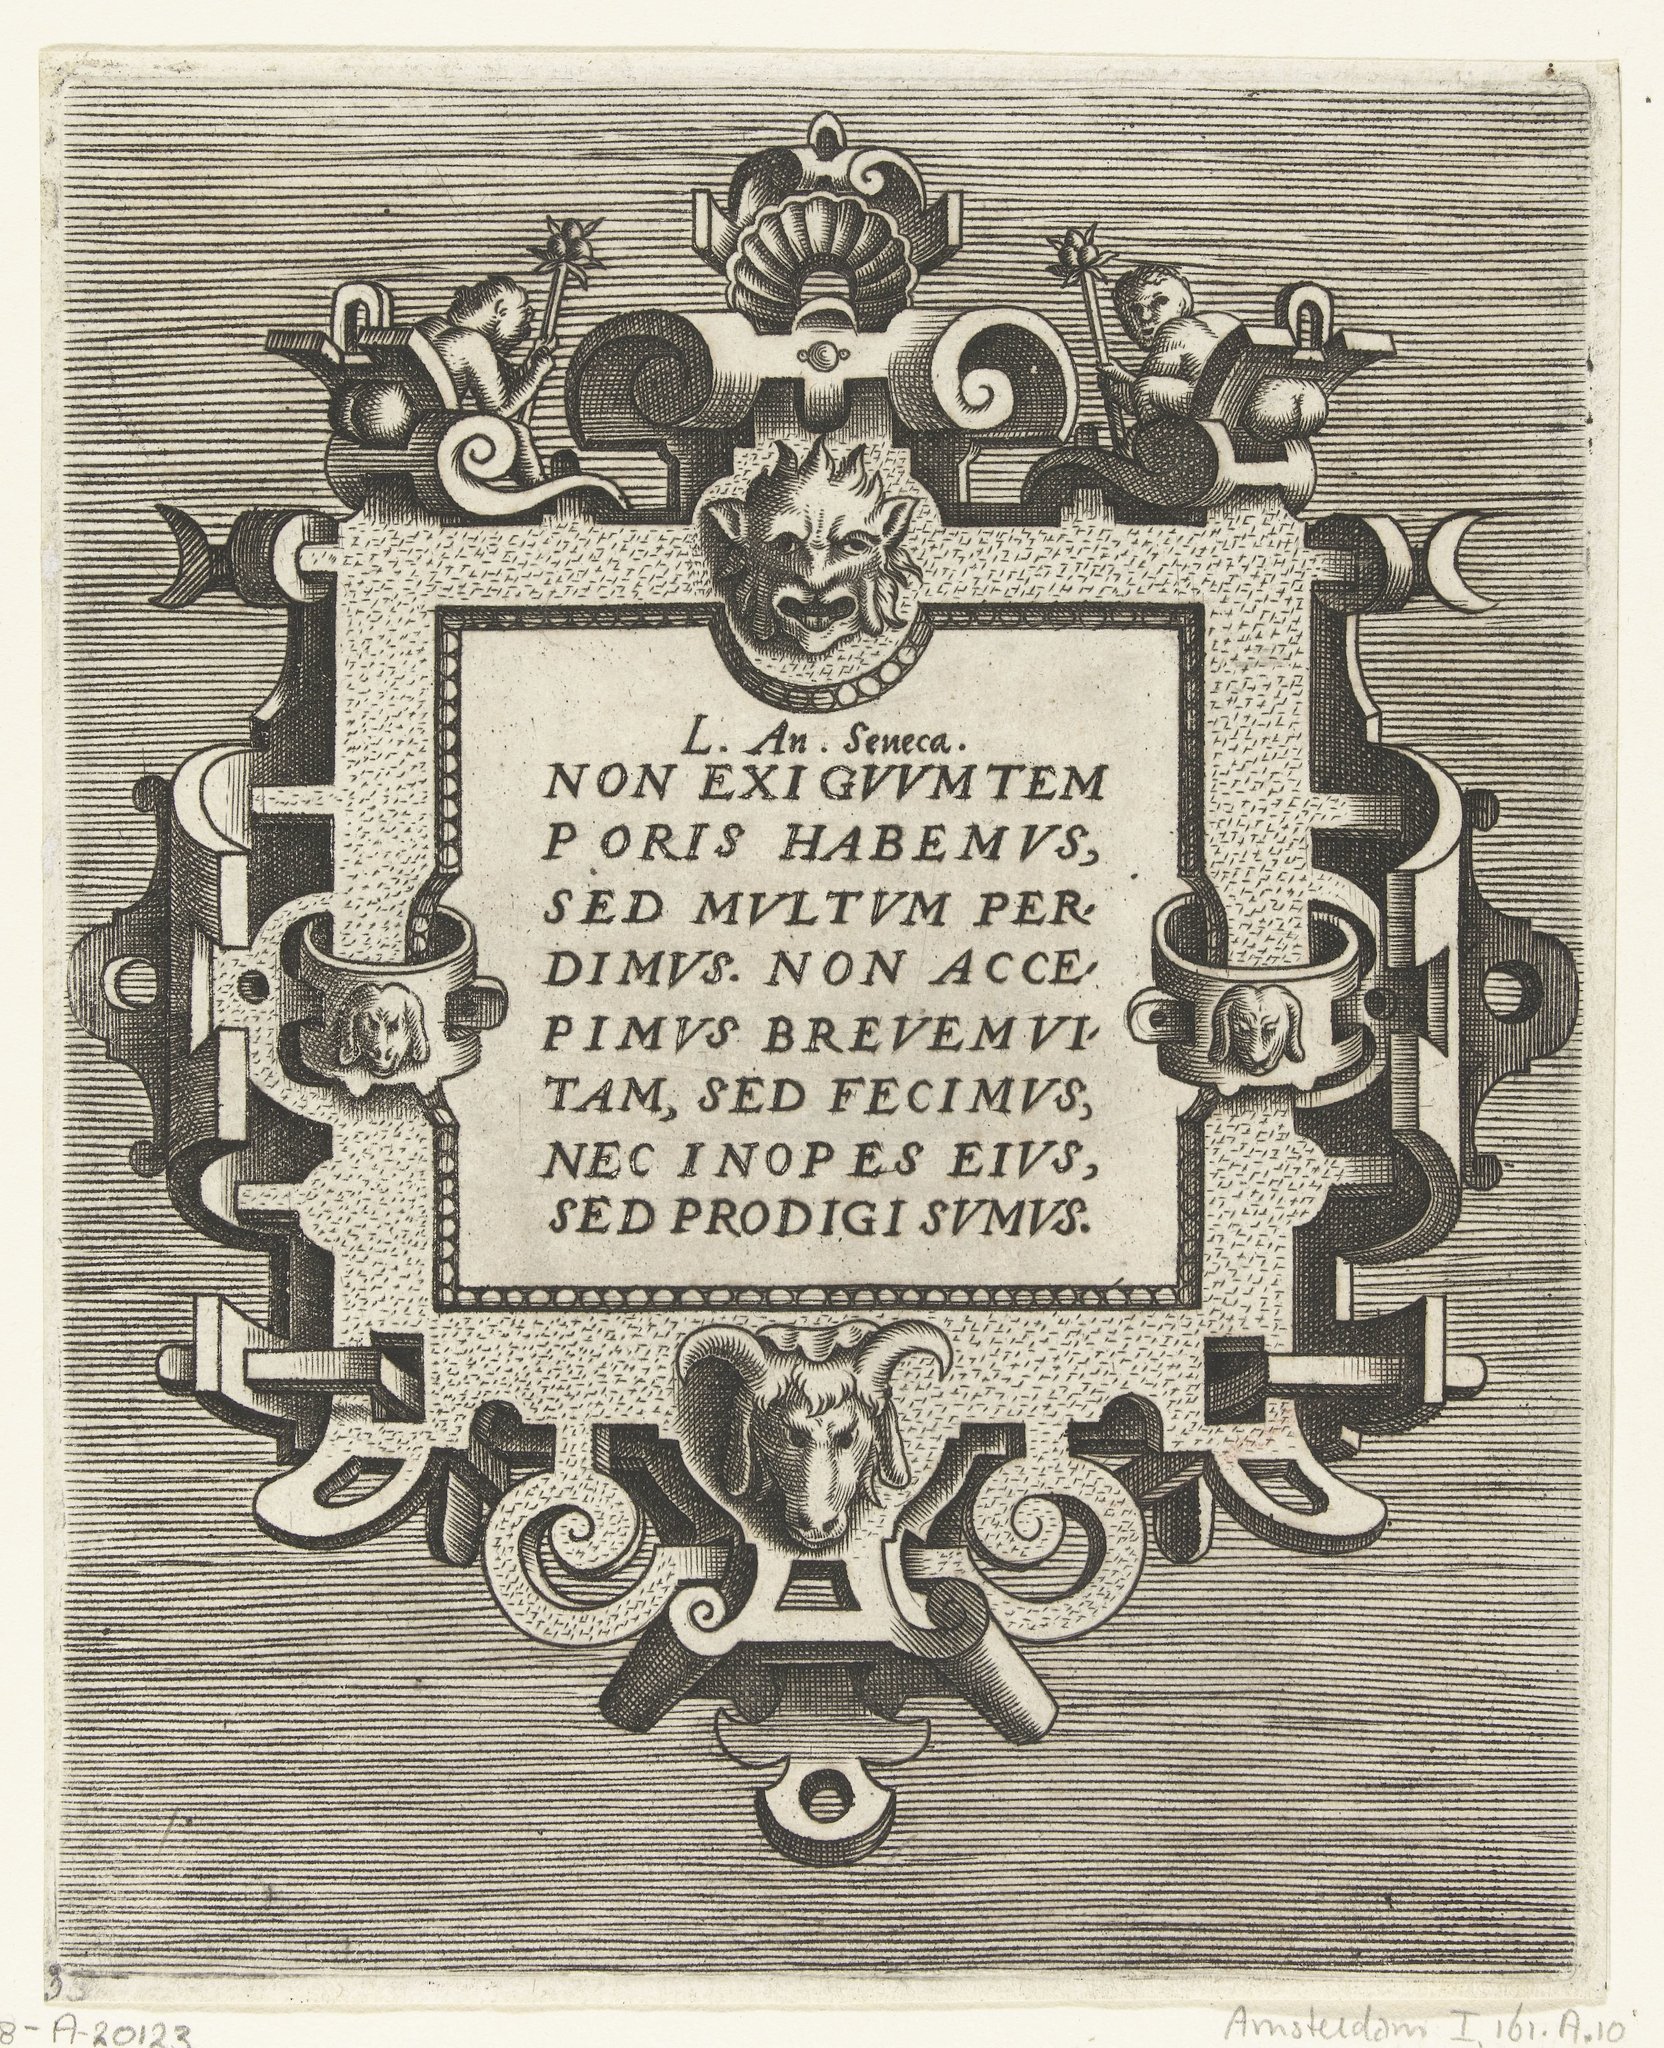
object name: print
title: Variarum protractionum (...)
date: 1557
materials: paper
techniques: etching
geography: netherlands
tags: ornament ~ cartouche, mask, mascaron ~ ornament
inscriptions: inscription: ‘j’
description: Linksboven en rechtsboven zit een kind waarvan de billen door het rolwerk heen steken. Op de cartouche zitten vier mascarons. Gearceerde achtergrond. Uit tweede editie van serie bestaande uit een titelblad en 12 cartouches met citaten van klassieke schrijvers in een omlijsting van rolwerk met grotesken, mascarons en guirlandes.